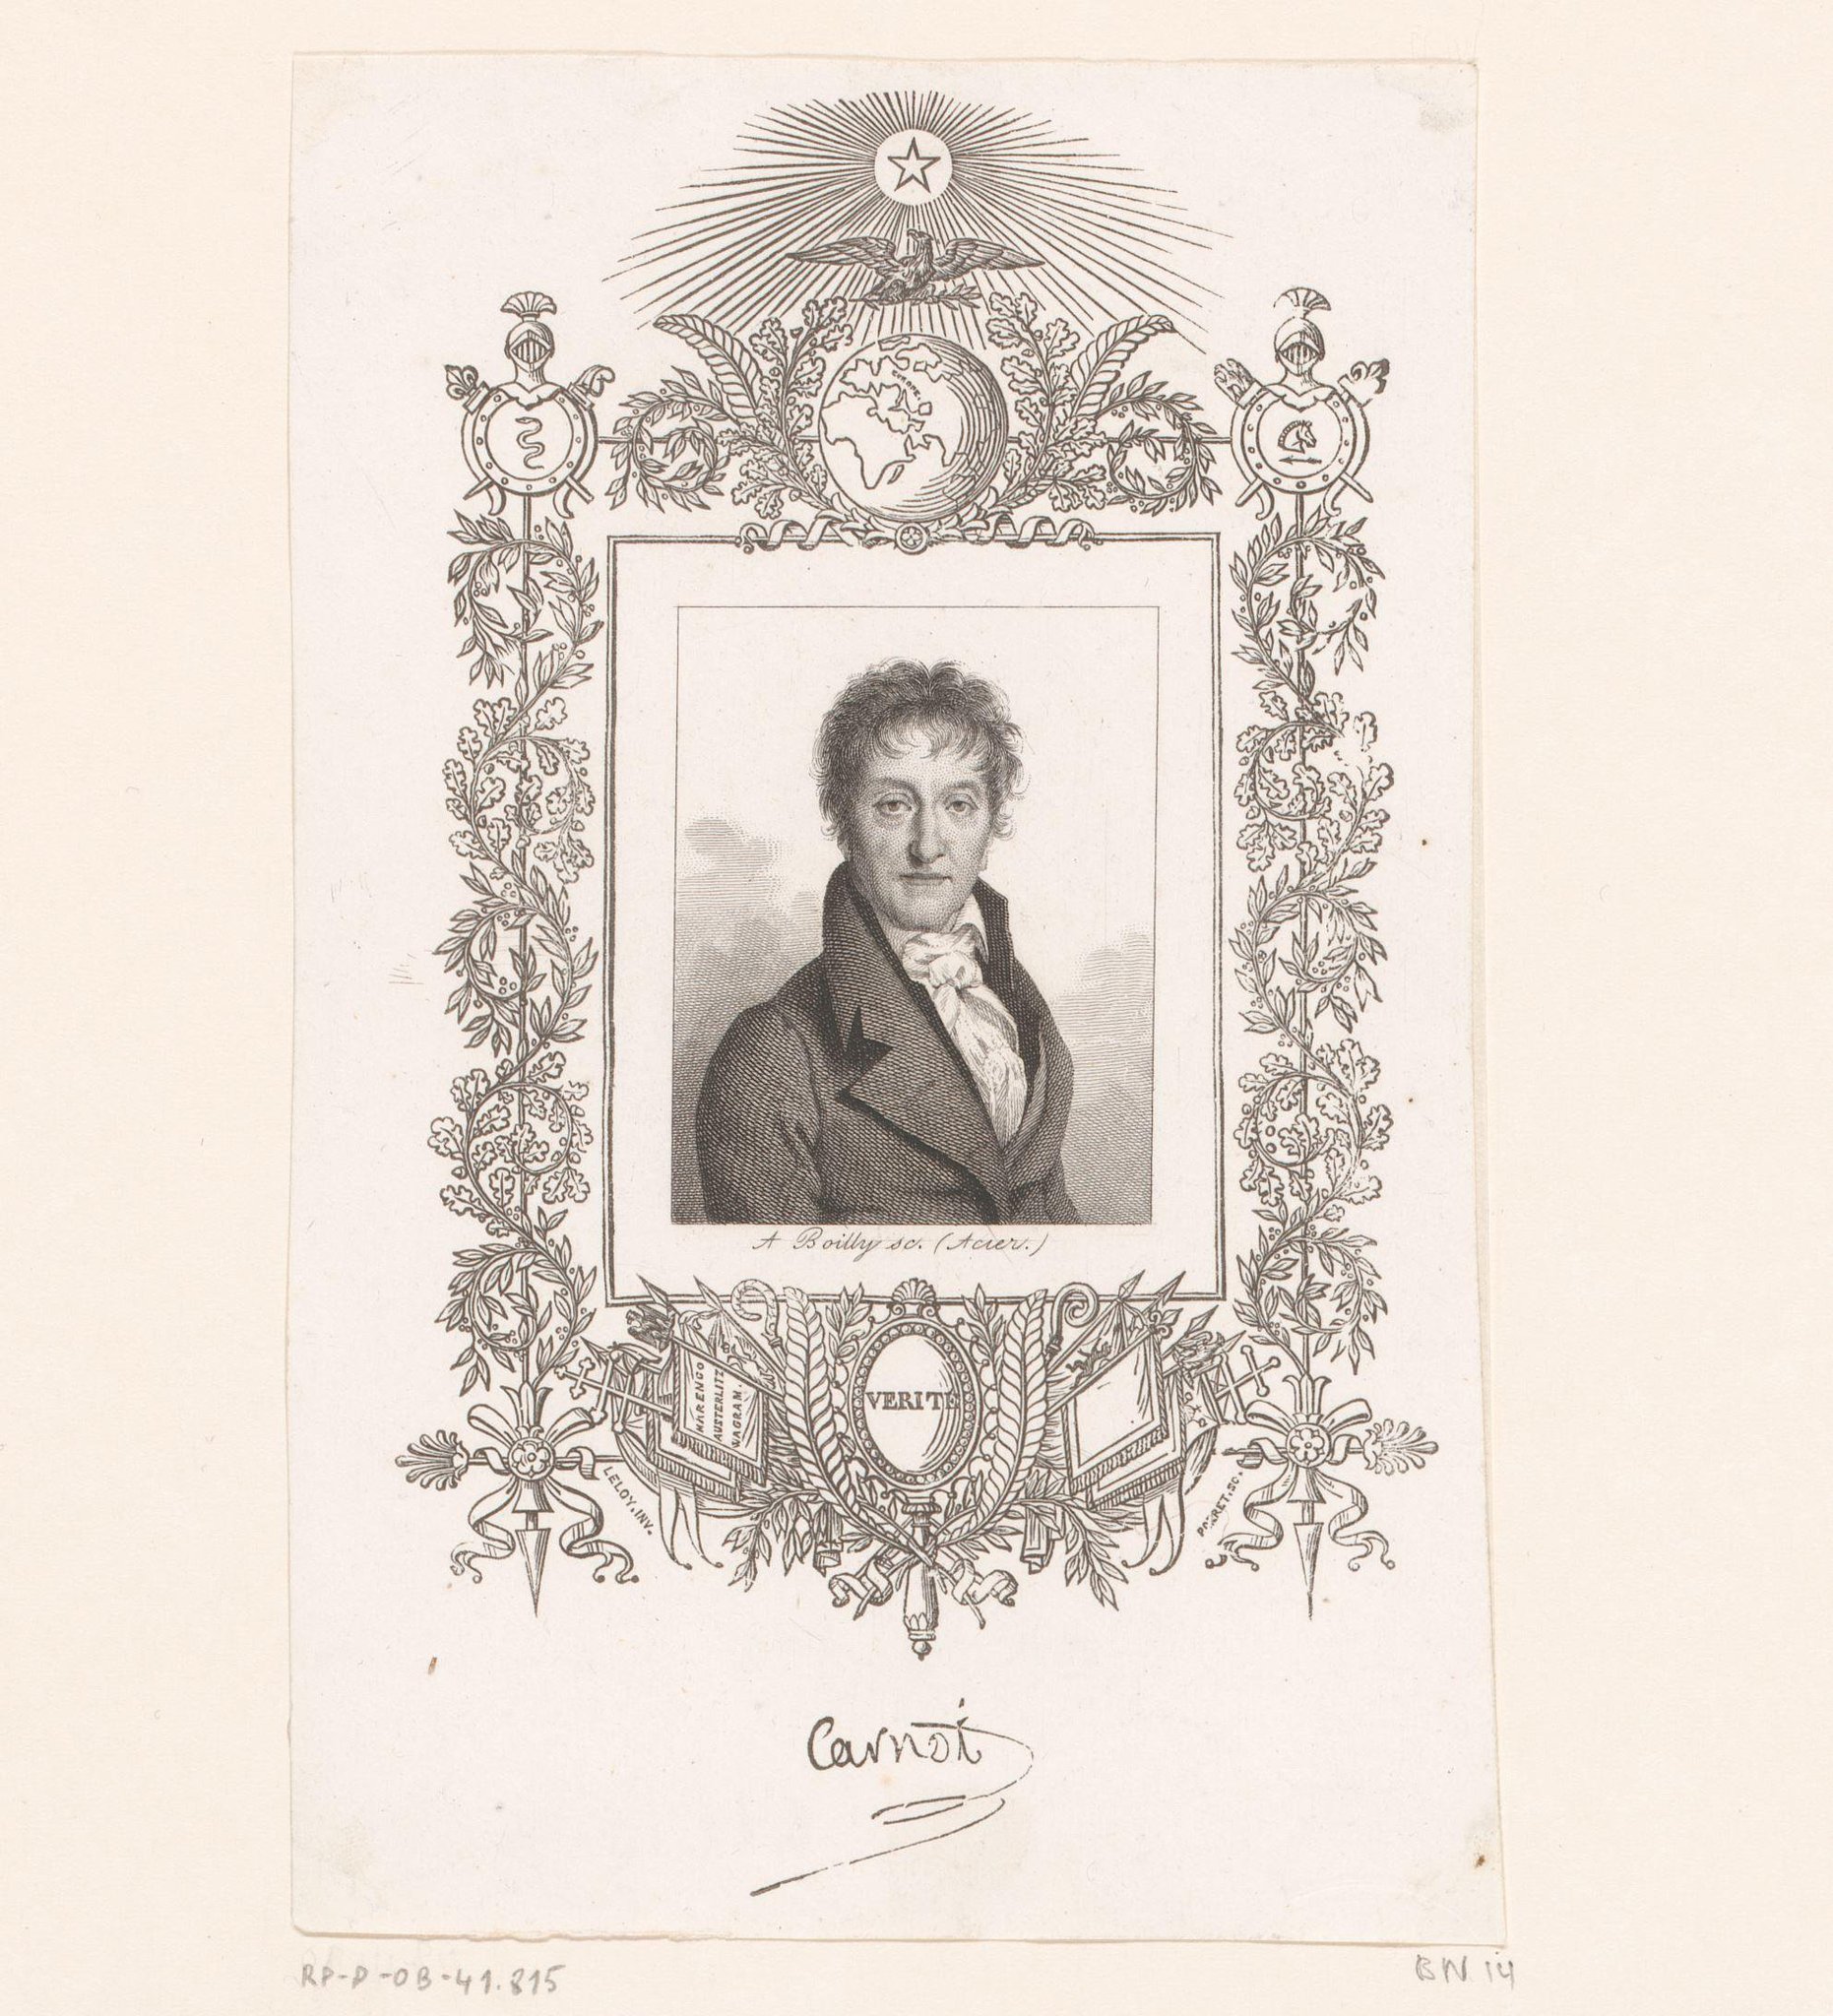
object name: print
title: Serie portretten van vooraanstaande personen onder het bewind van Napoleon Bonaparte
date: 1811-1867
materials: paper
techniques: engraving, etching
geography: france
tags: historical persons, ornament ~ cartouche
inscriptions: check stamp, collector's mark: Lugt 2228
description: Dit portret maakte deel uit van de serie "Galerie Napoléon", een collectie van honderd portretten van vooraanstaande figuren uit de omgeving van Napoleon Bonaparte. De serie werd uitgegeven door Bénard in Parijs in 1829-30.